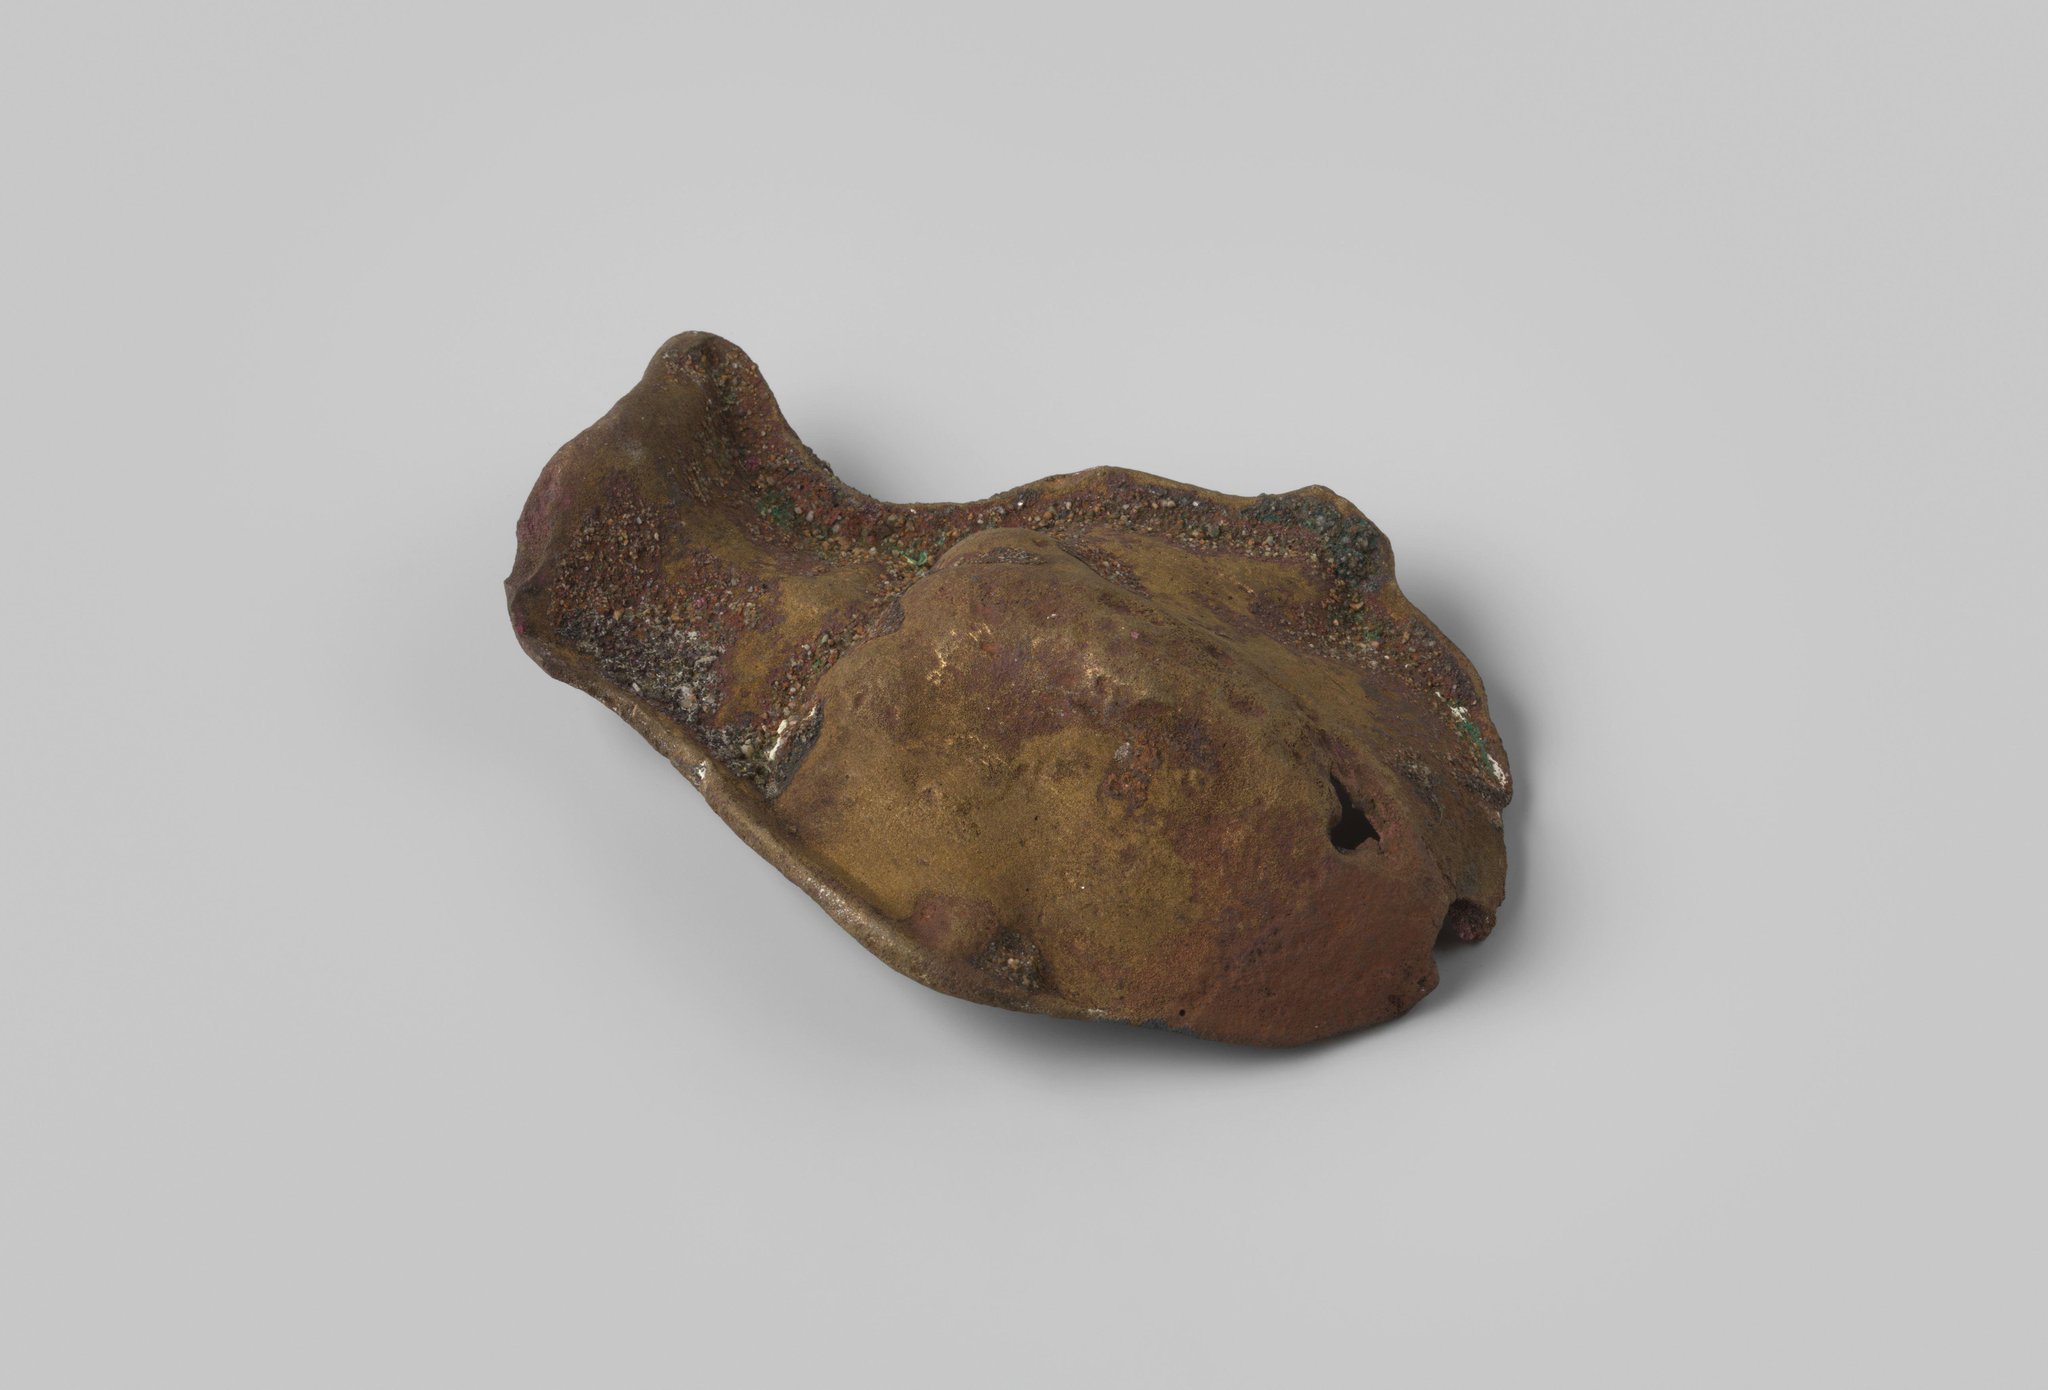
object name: flask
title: Gietmal uit het wrak van de Oost-Indiëvaarder Hollandia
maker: Anonymous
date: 1700-1743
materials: copper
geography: netherlands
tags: verenigde oostindische compagnie, hollandia (schip), annet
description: Tools and instruments, lead casting, mould; countermould of mould NG-1979-196-H-3006, eroded, on the reverse handle fitting and inscription id. NG-1979-192-H-3074.